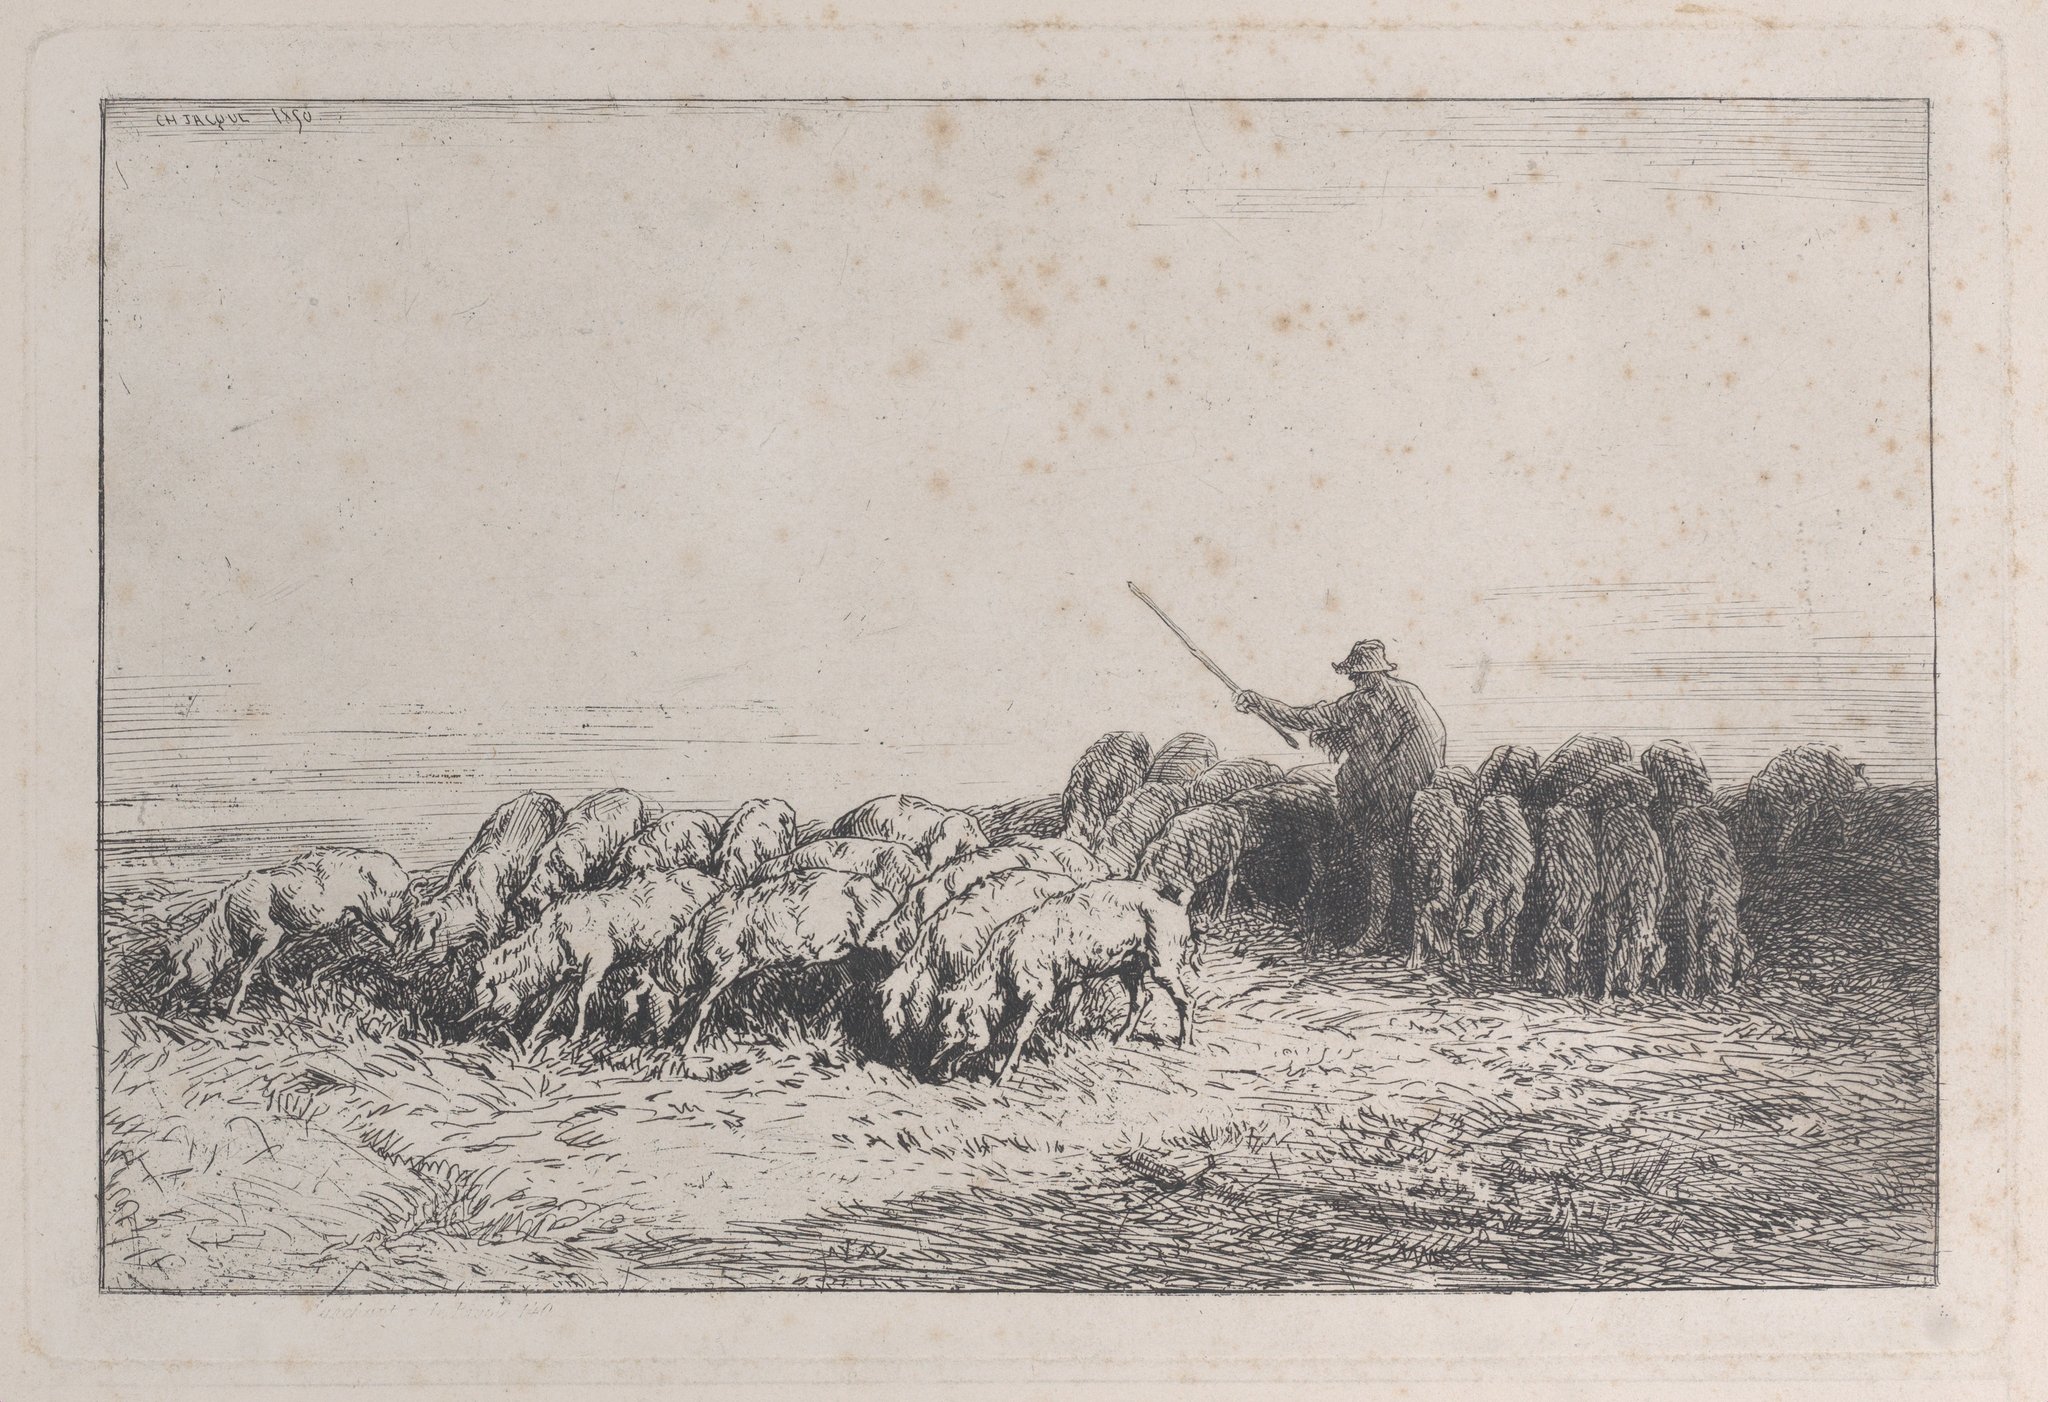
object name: print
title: A Herd of Pigs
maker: charles émile jacque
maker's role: artist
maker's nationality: french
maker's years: 1813-1894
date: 1850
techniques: etching